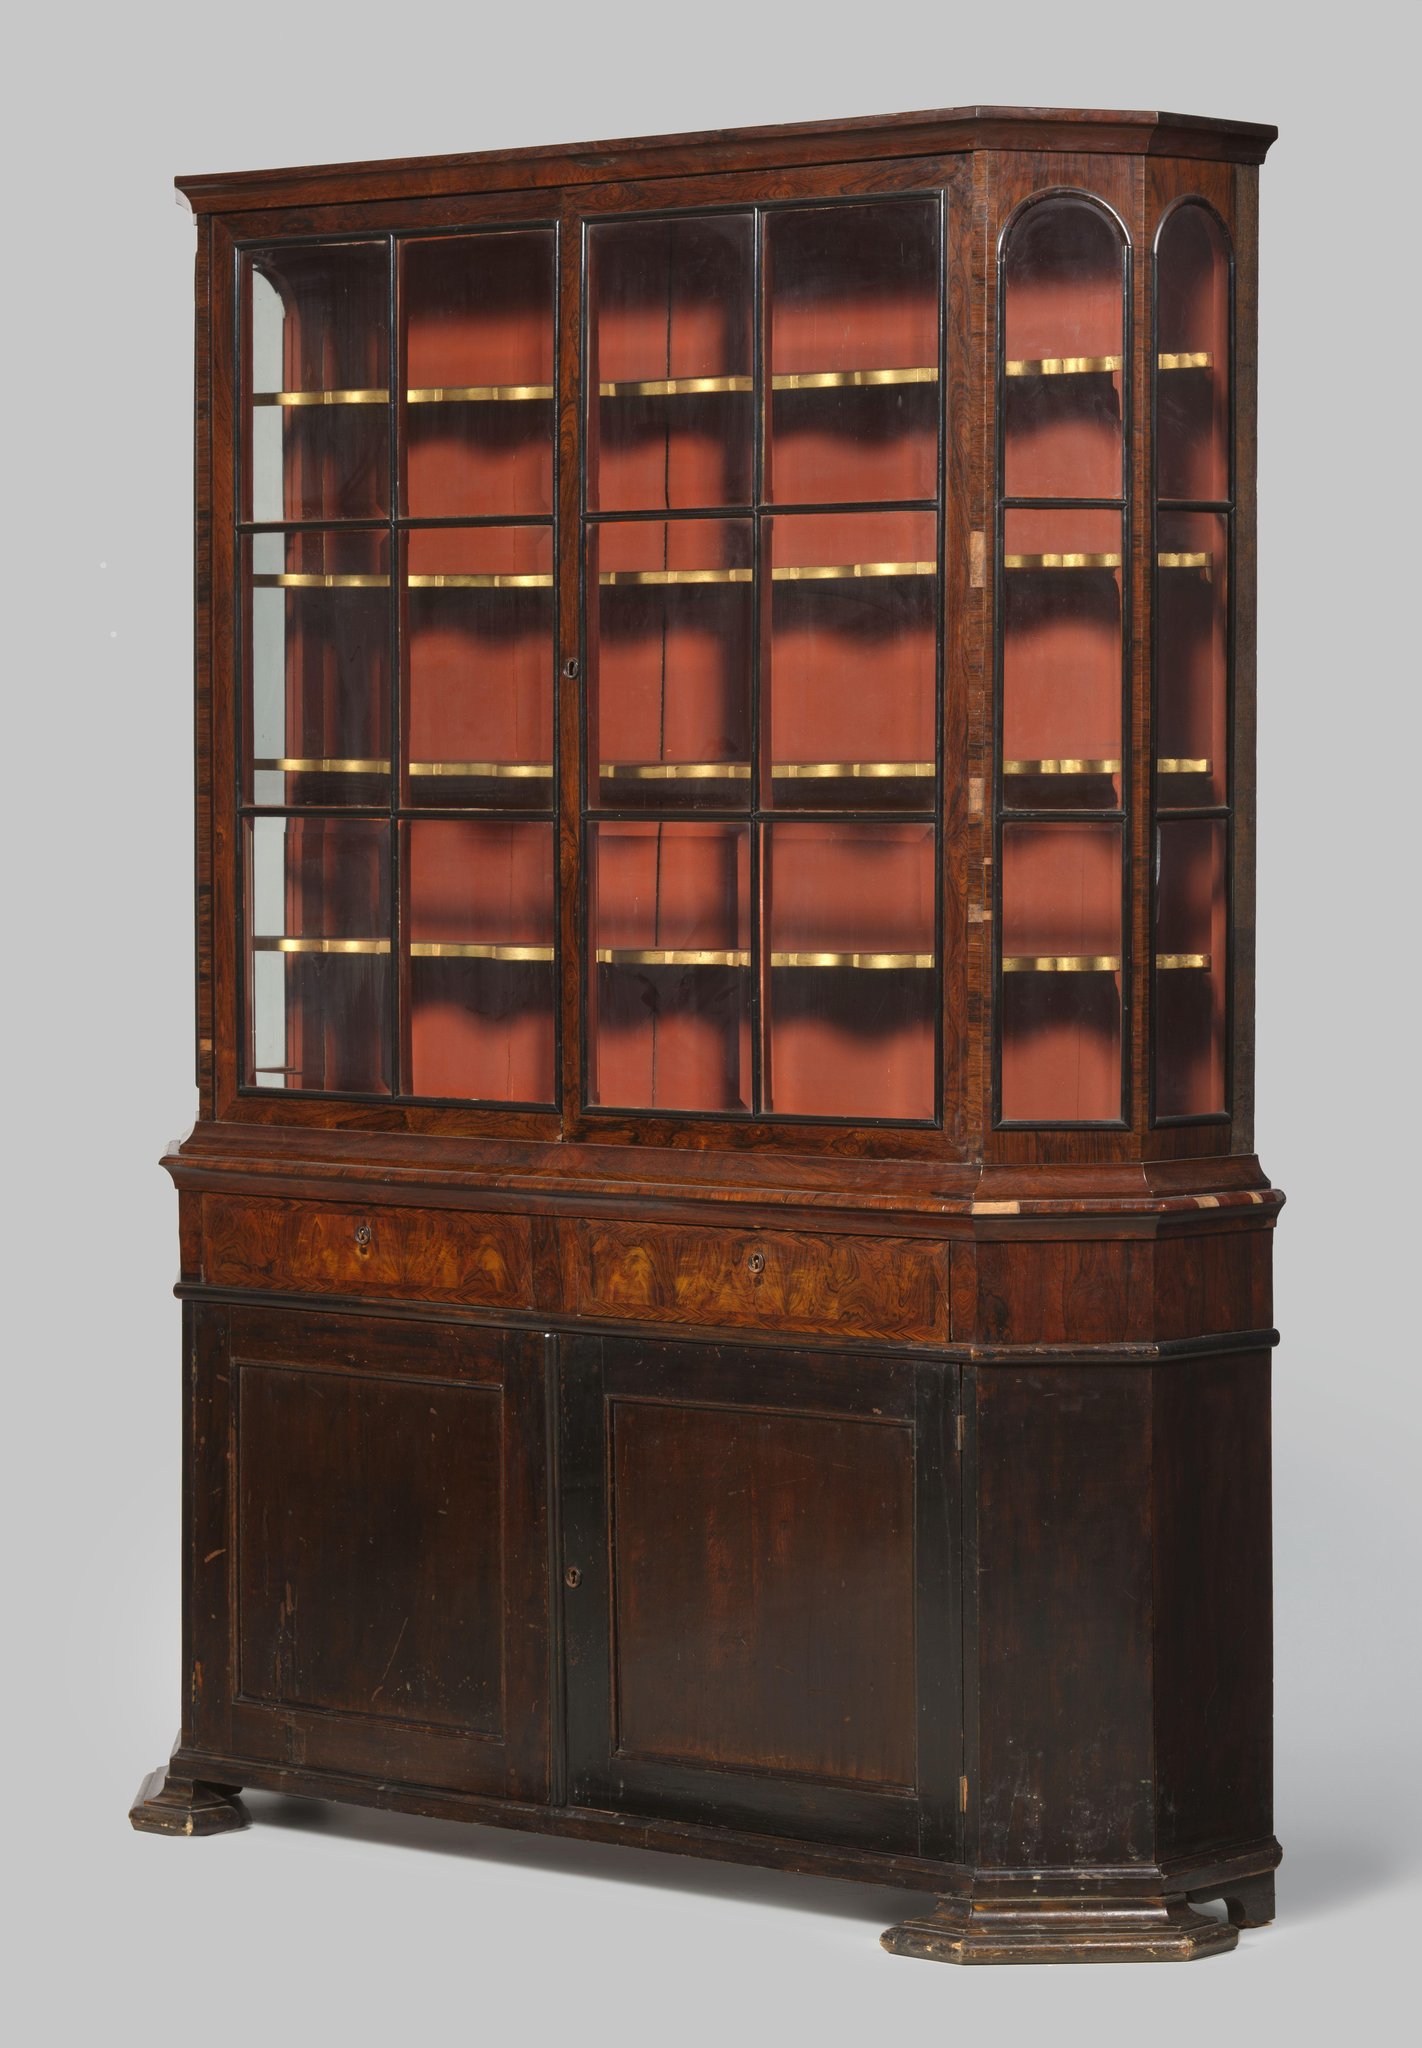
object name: case furniture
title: Porseleinkast met boven- en onderkast, resp. met ruiten en met twee deuren en een paneel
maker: Anonymous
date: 1800-1849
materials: glass, wood, paint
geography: netherlands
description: Porseleinkast van palissanderhout bestaande uit een bovenkast met ruiten en een onderkast met twee deuren in paneel.